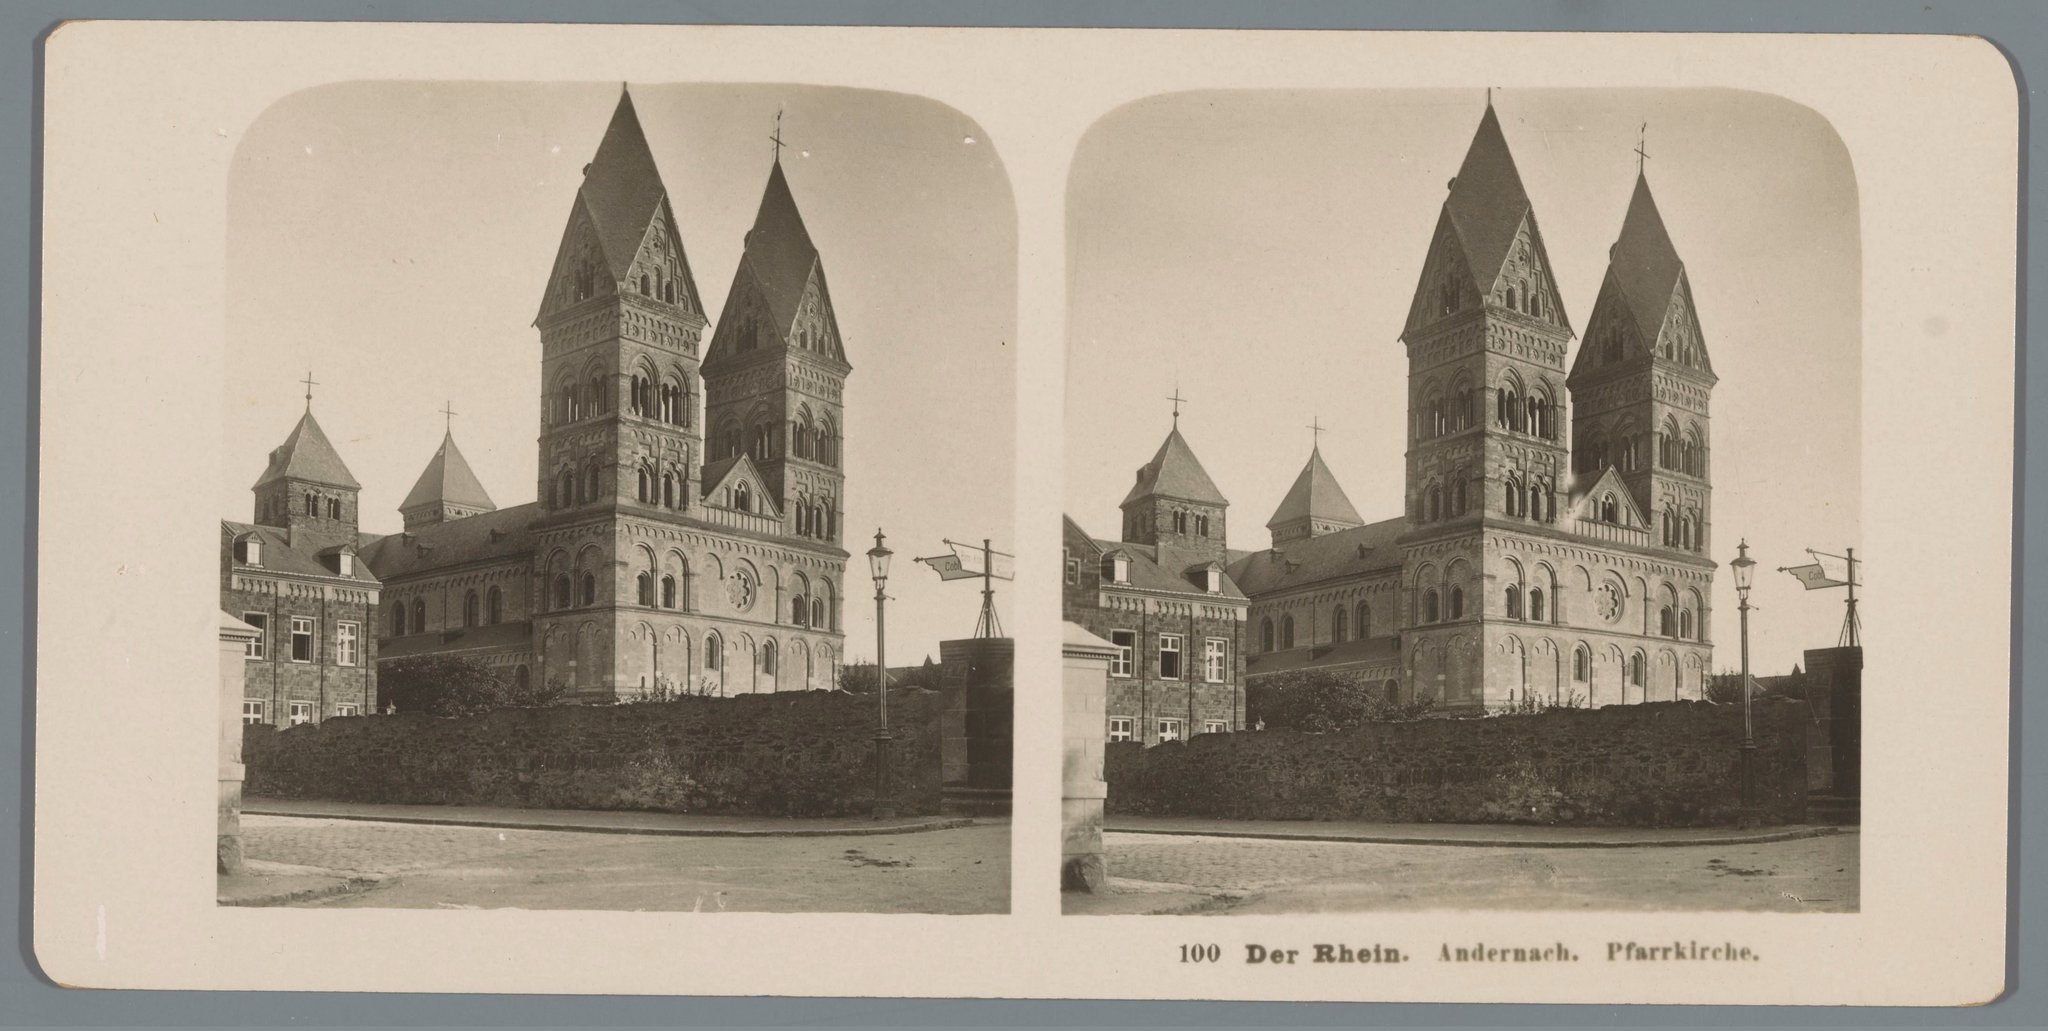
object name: stereograph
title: Der Rhein. Andernach. Pfarrkirche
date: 1903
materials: cardboard, photographic support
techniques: gelatin silver print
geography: andernach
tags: church (exterior), façade (of house or building)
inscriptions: number: ‘100’, inscription: ‘Neue Photographische Gesellschaft A.G. Steglitz-Berlin 1903.’